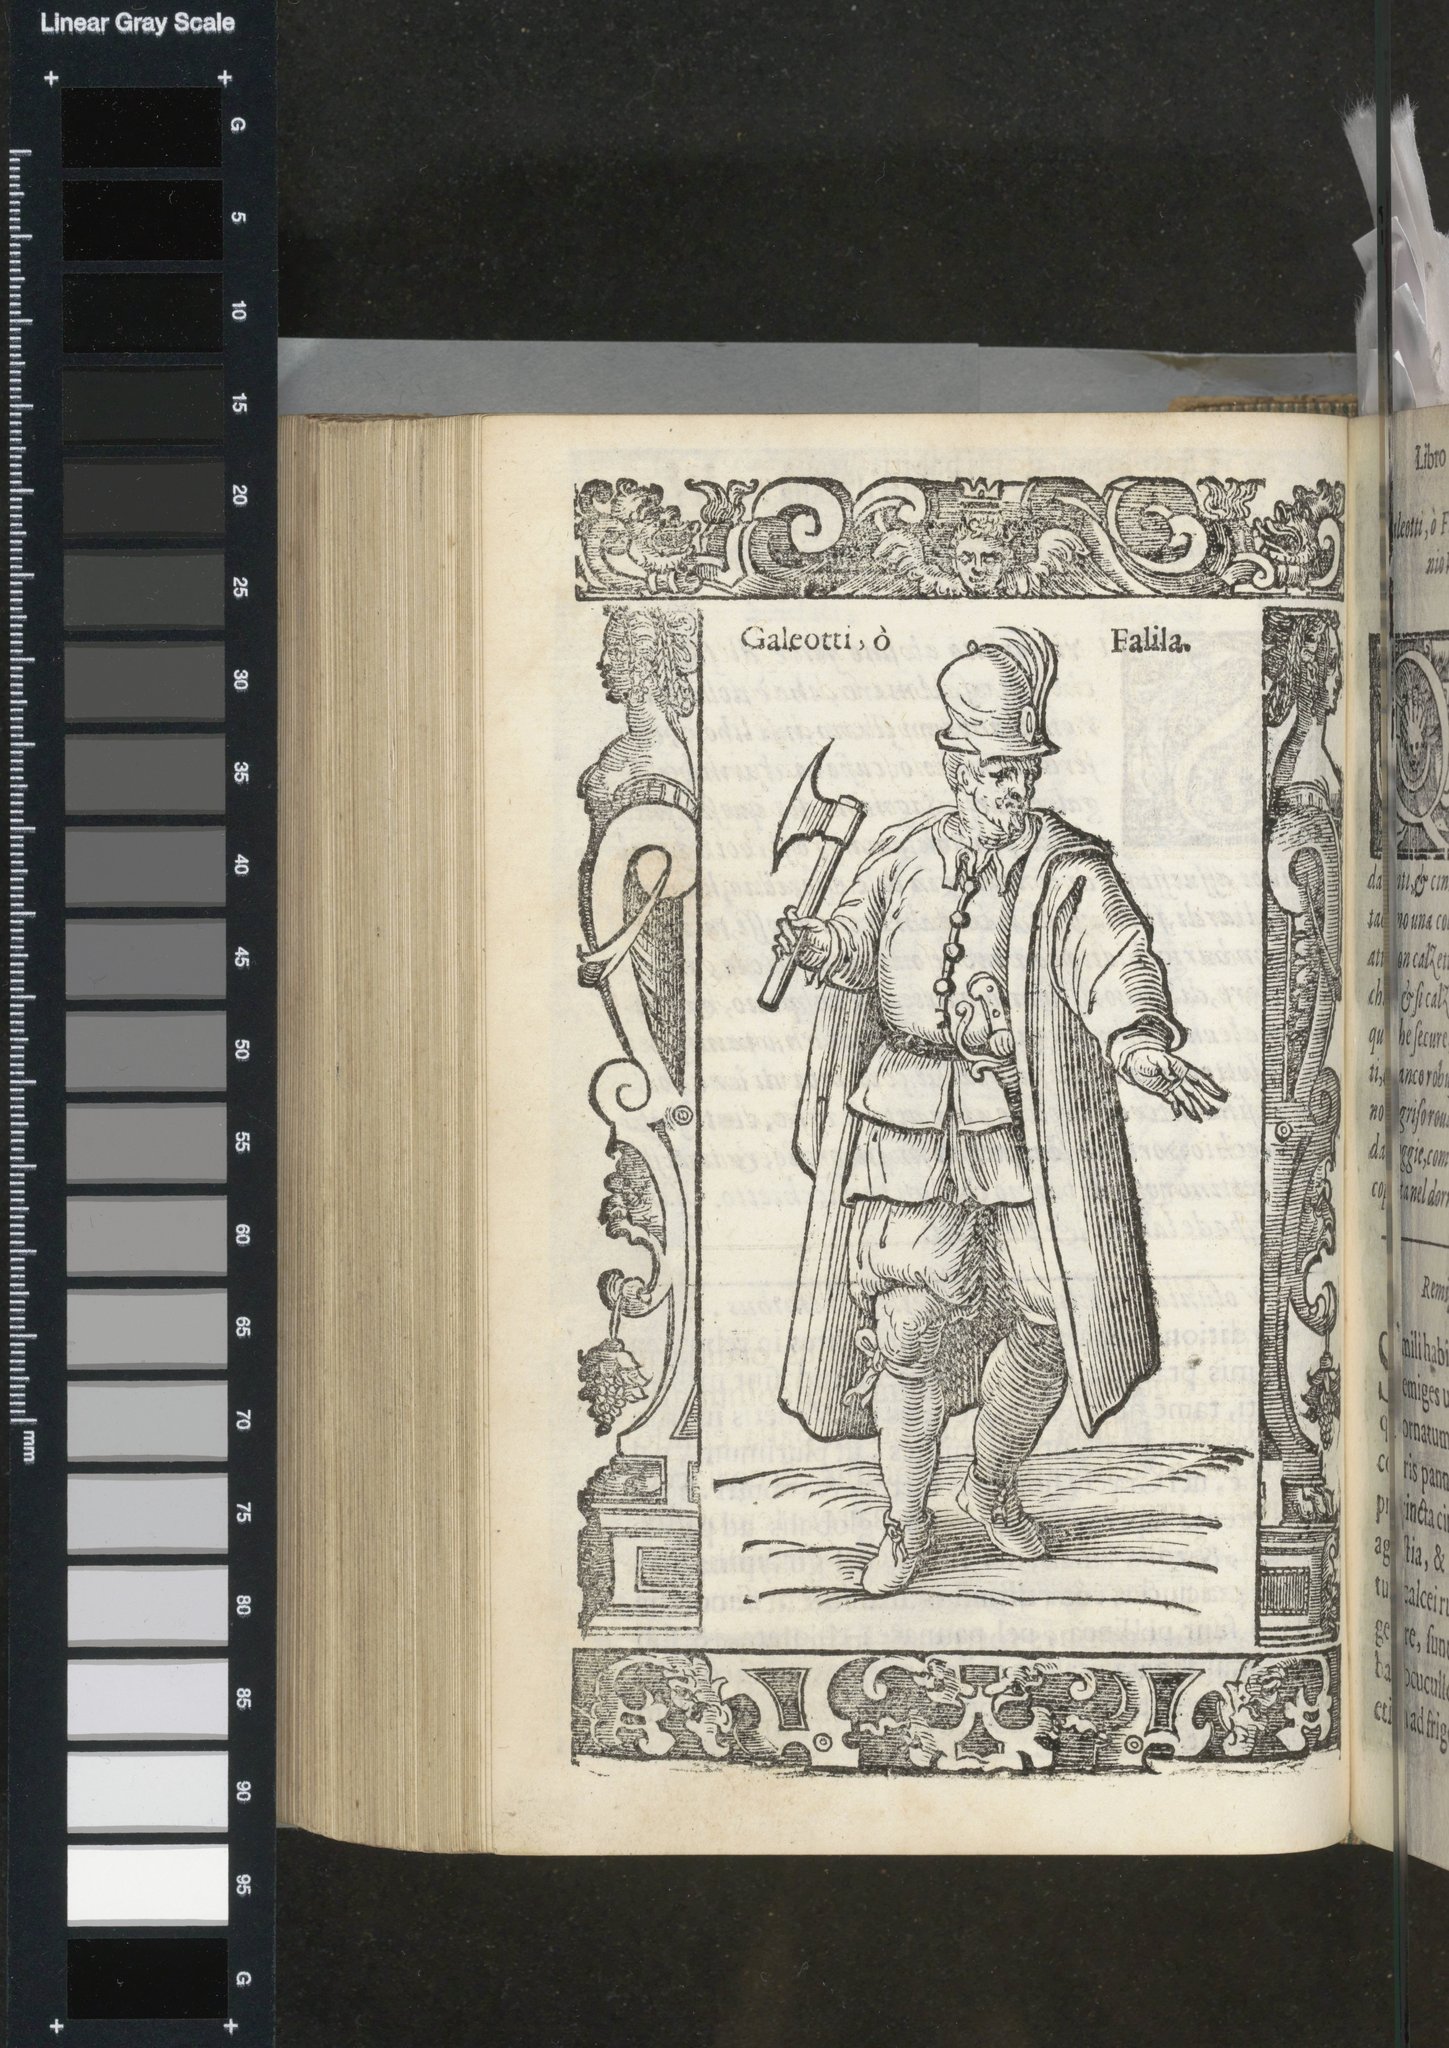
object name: costume print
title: Habiti antichi, et moderni di tutto il mondo...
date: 1598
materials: paper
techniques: woodcut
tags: fashion plates